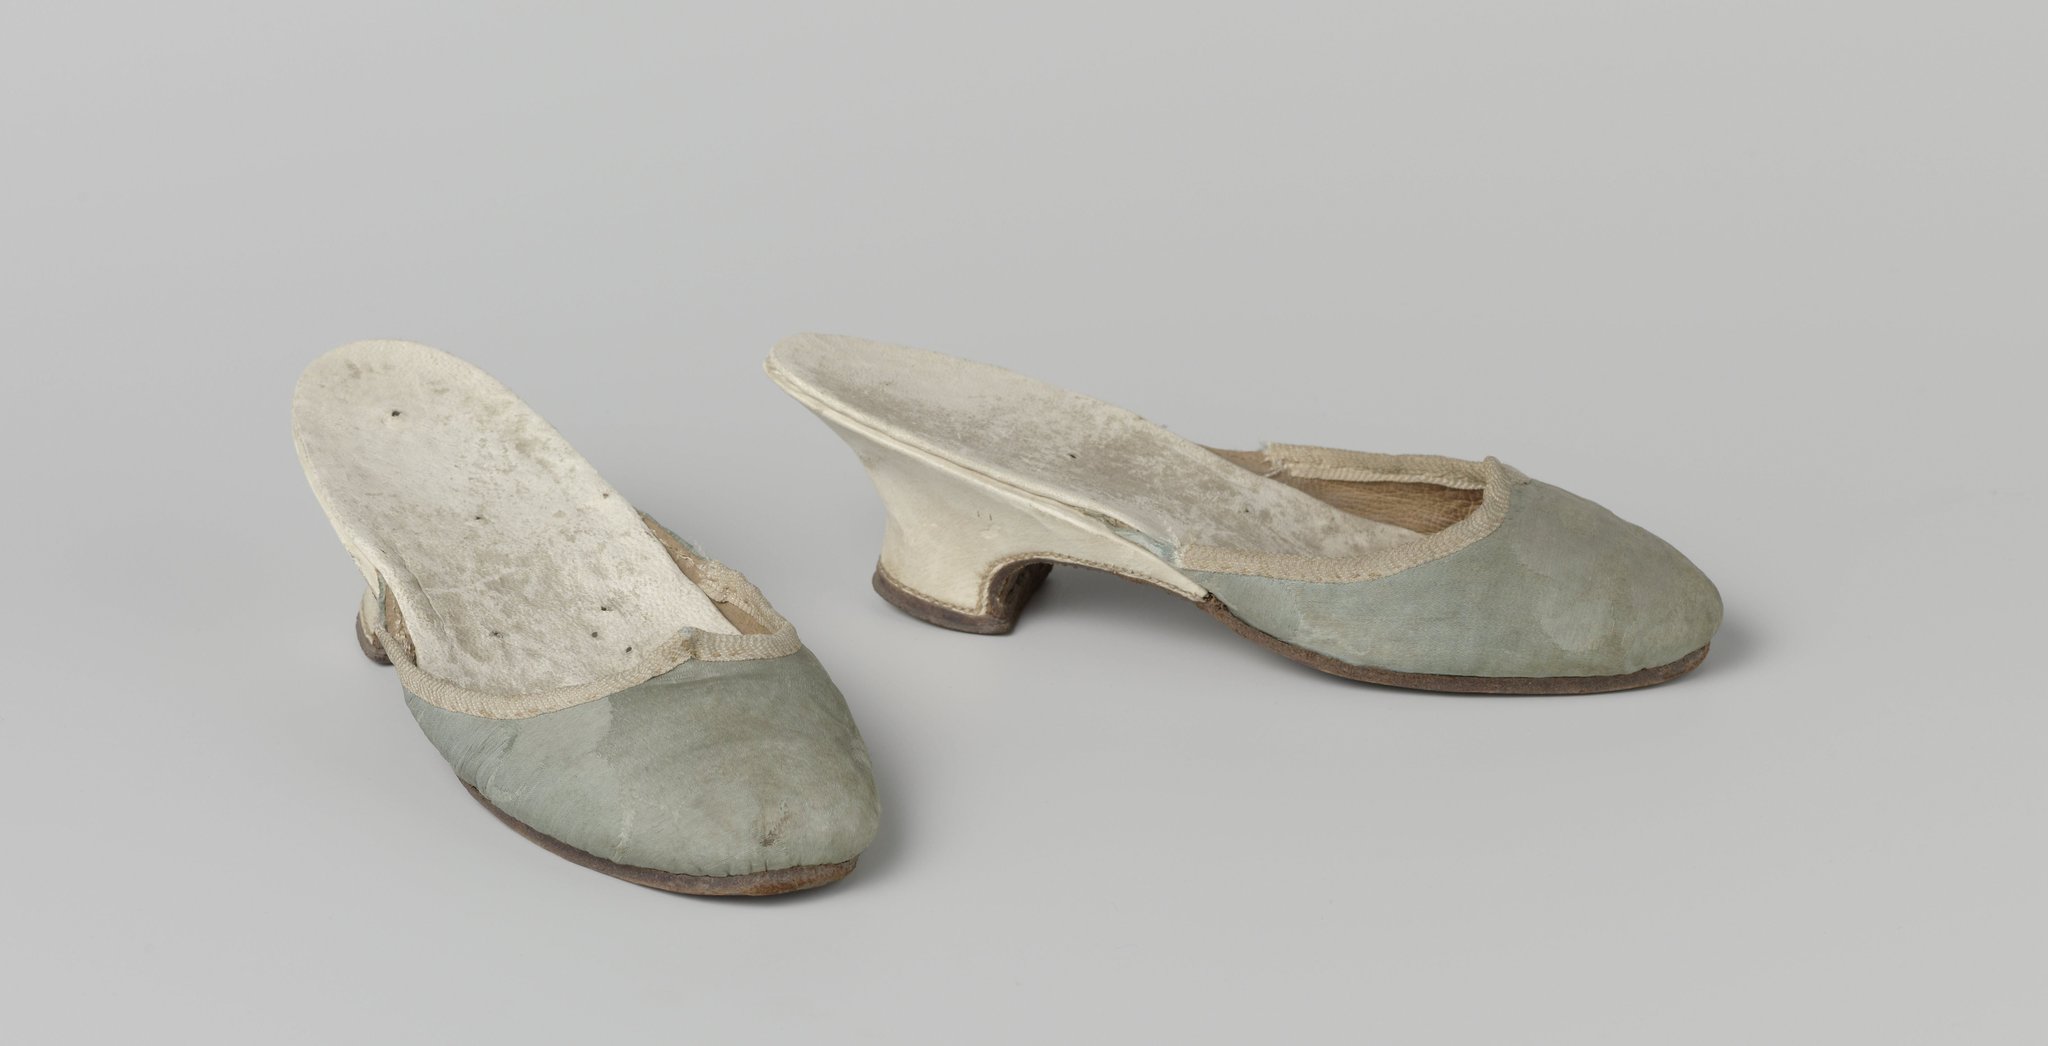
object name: womenswear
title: Damesmuiltje met voorblad van blauwe zijdendamast, binnenzool en hak overtrokken met wit glacéleer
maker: Anonymous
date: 1750-1800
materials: silk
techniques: weave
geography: netherlands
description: Damesmuiltje met voorblad van blauwe zijdendamast, binnenzool en hak overtrokken met wit glacéleer.